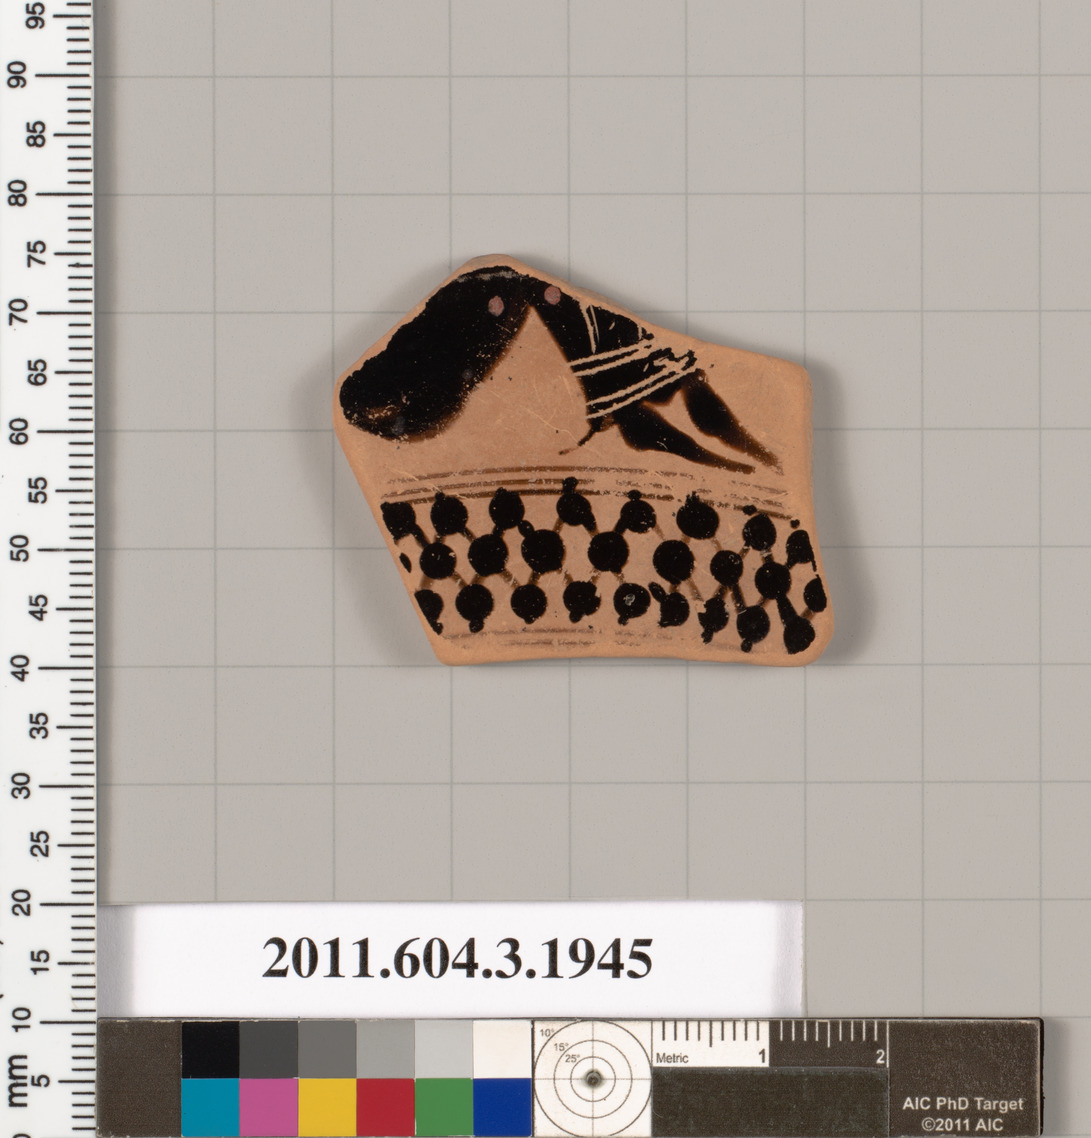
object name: kylix fragment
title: Terracotta fragment of a kylix: Cassel cup (drinking cup)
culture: greek, attic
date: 575-551 BCE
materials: terracotta